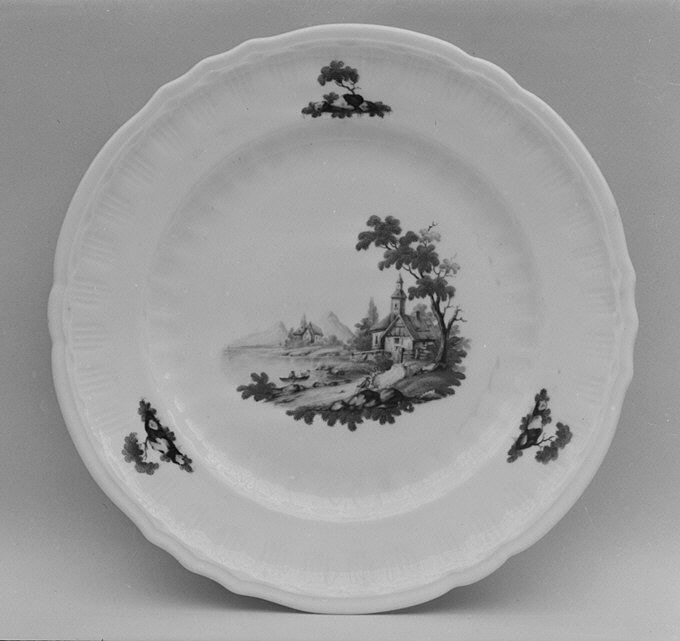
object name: plate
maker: zurich pottery and porcelain factory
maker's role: factory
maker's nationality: swiss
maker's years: 1763-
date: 1780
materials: hard paste porcelain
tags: houses,trees